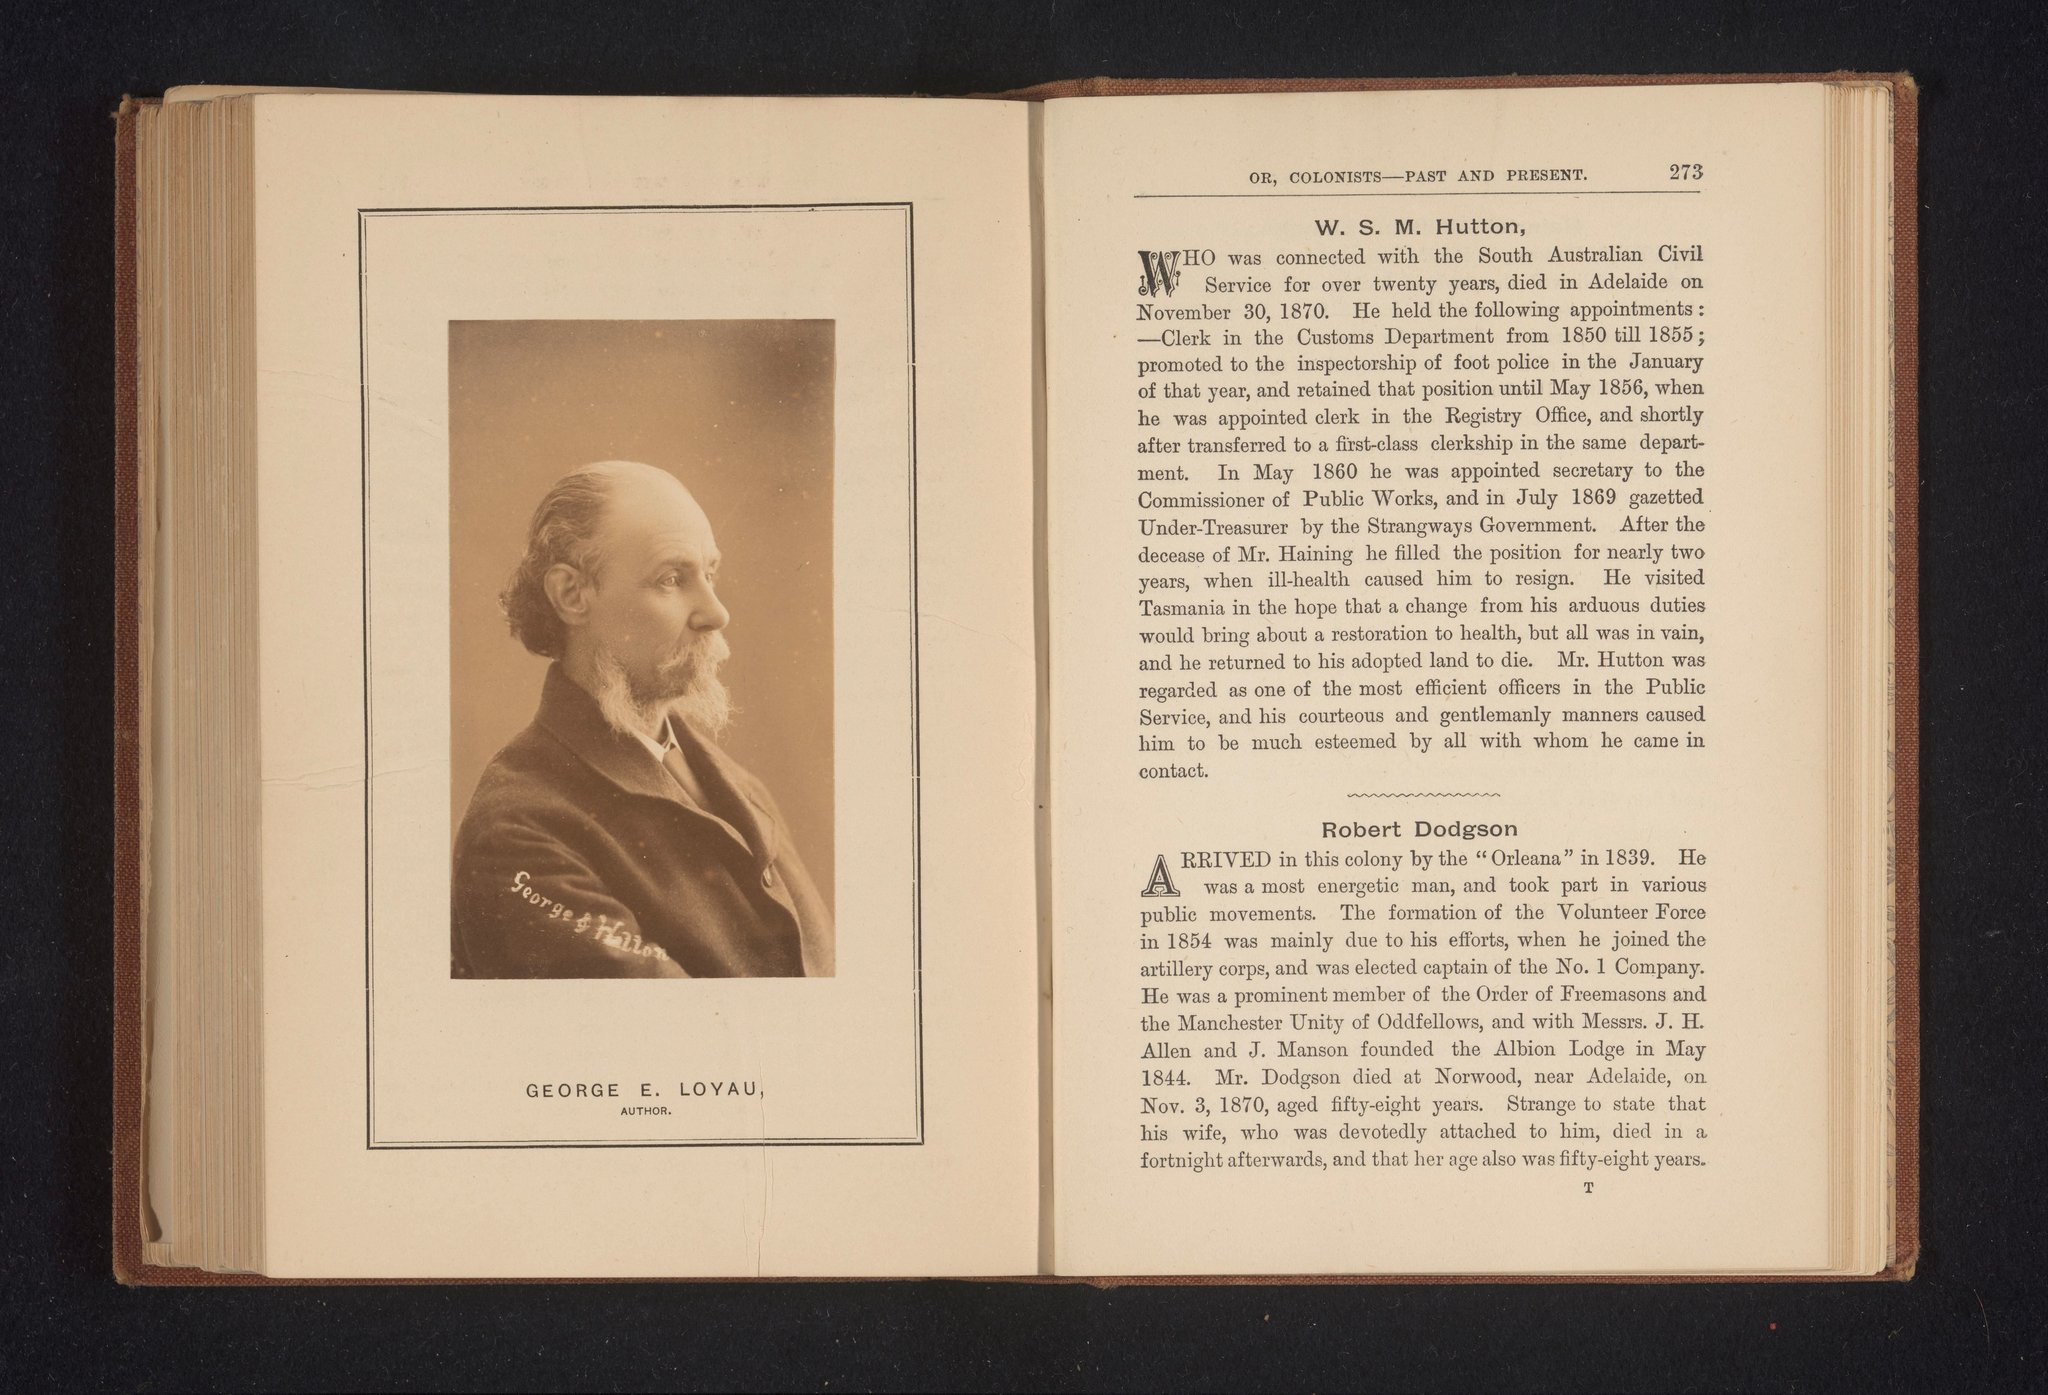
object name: page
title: George E. Loyau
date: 1875-1885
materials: photographic support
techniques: albumen print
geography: adelaide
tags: london, george ettienne loyau, portrait of a writer